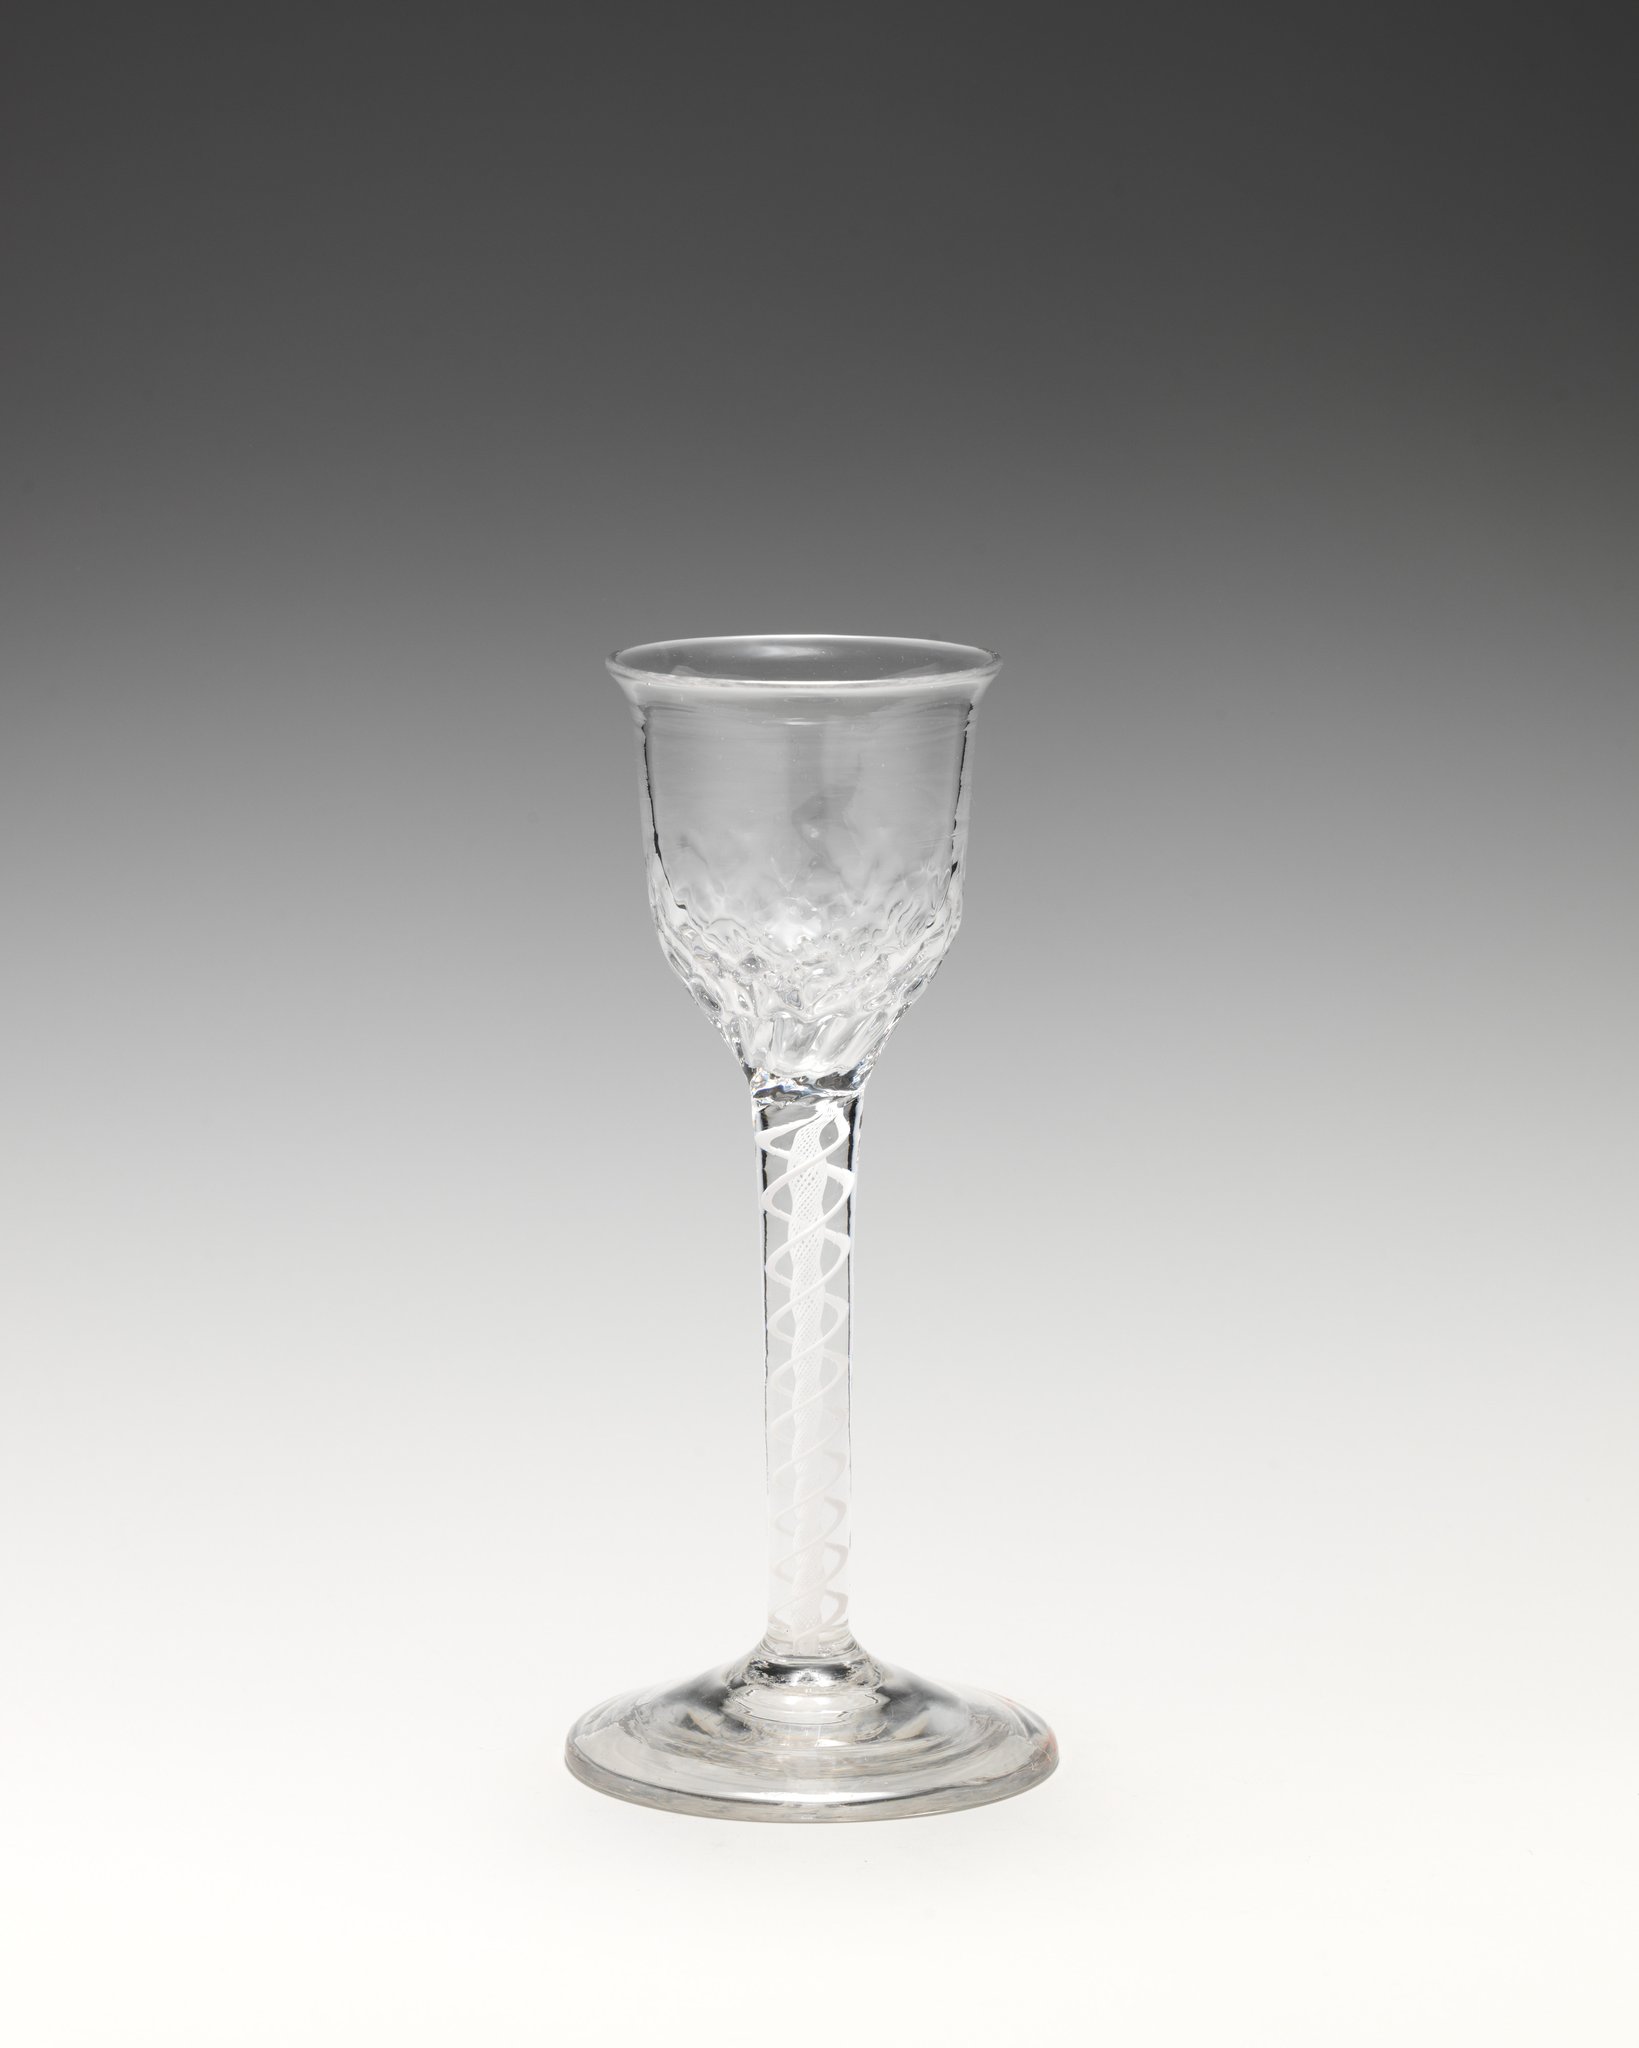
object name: wineglass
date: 1767-1800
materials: glass